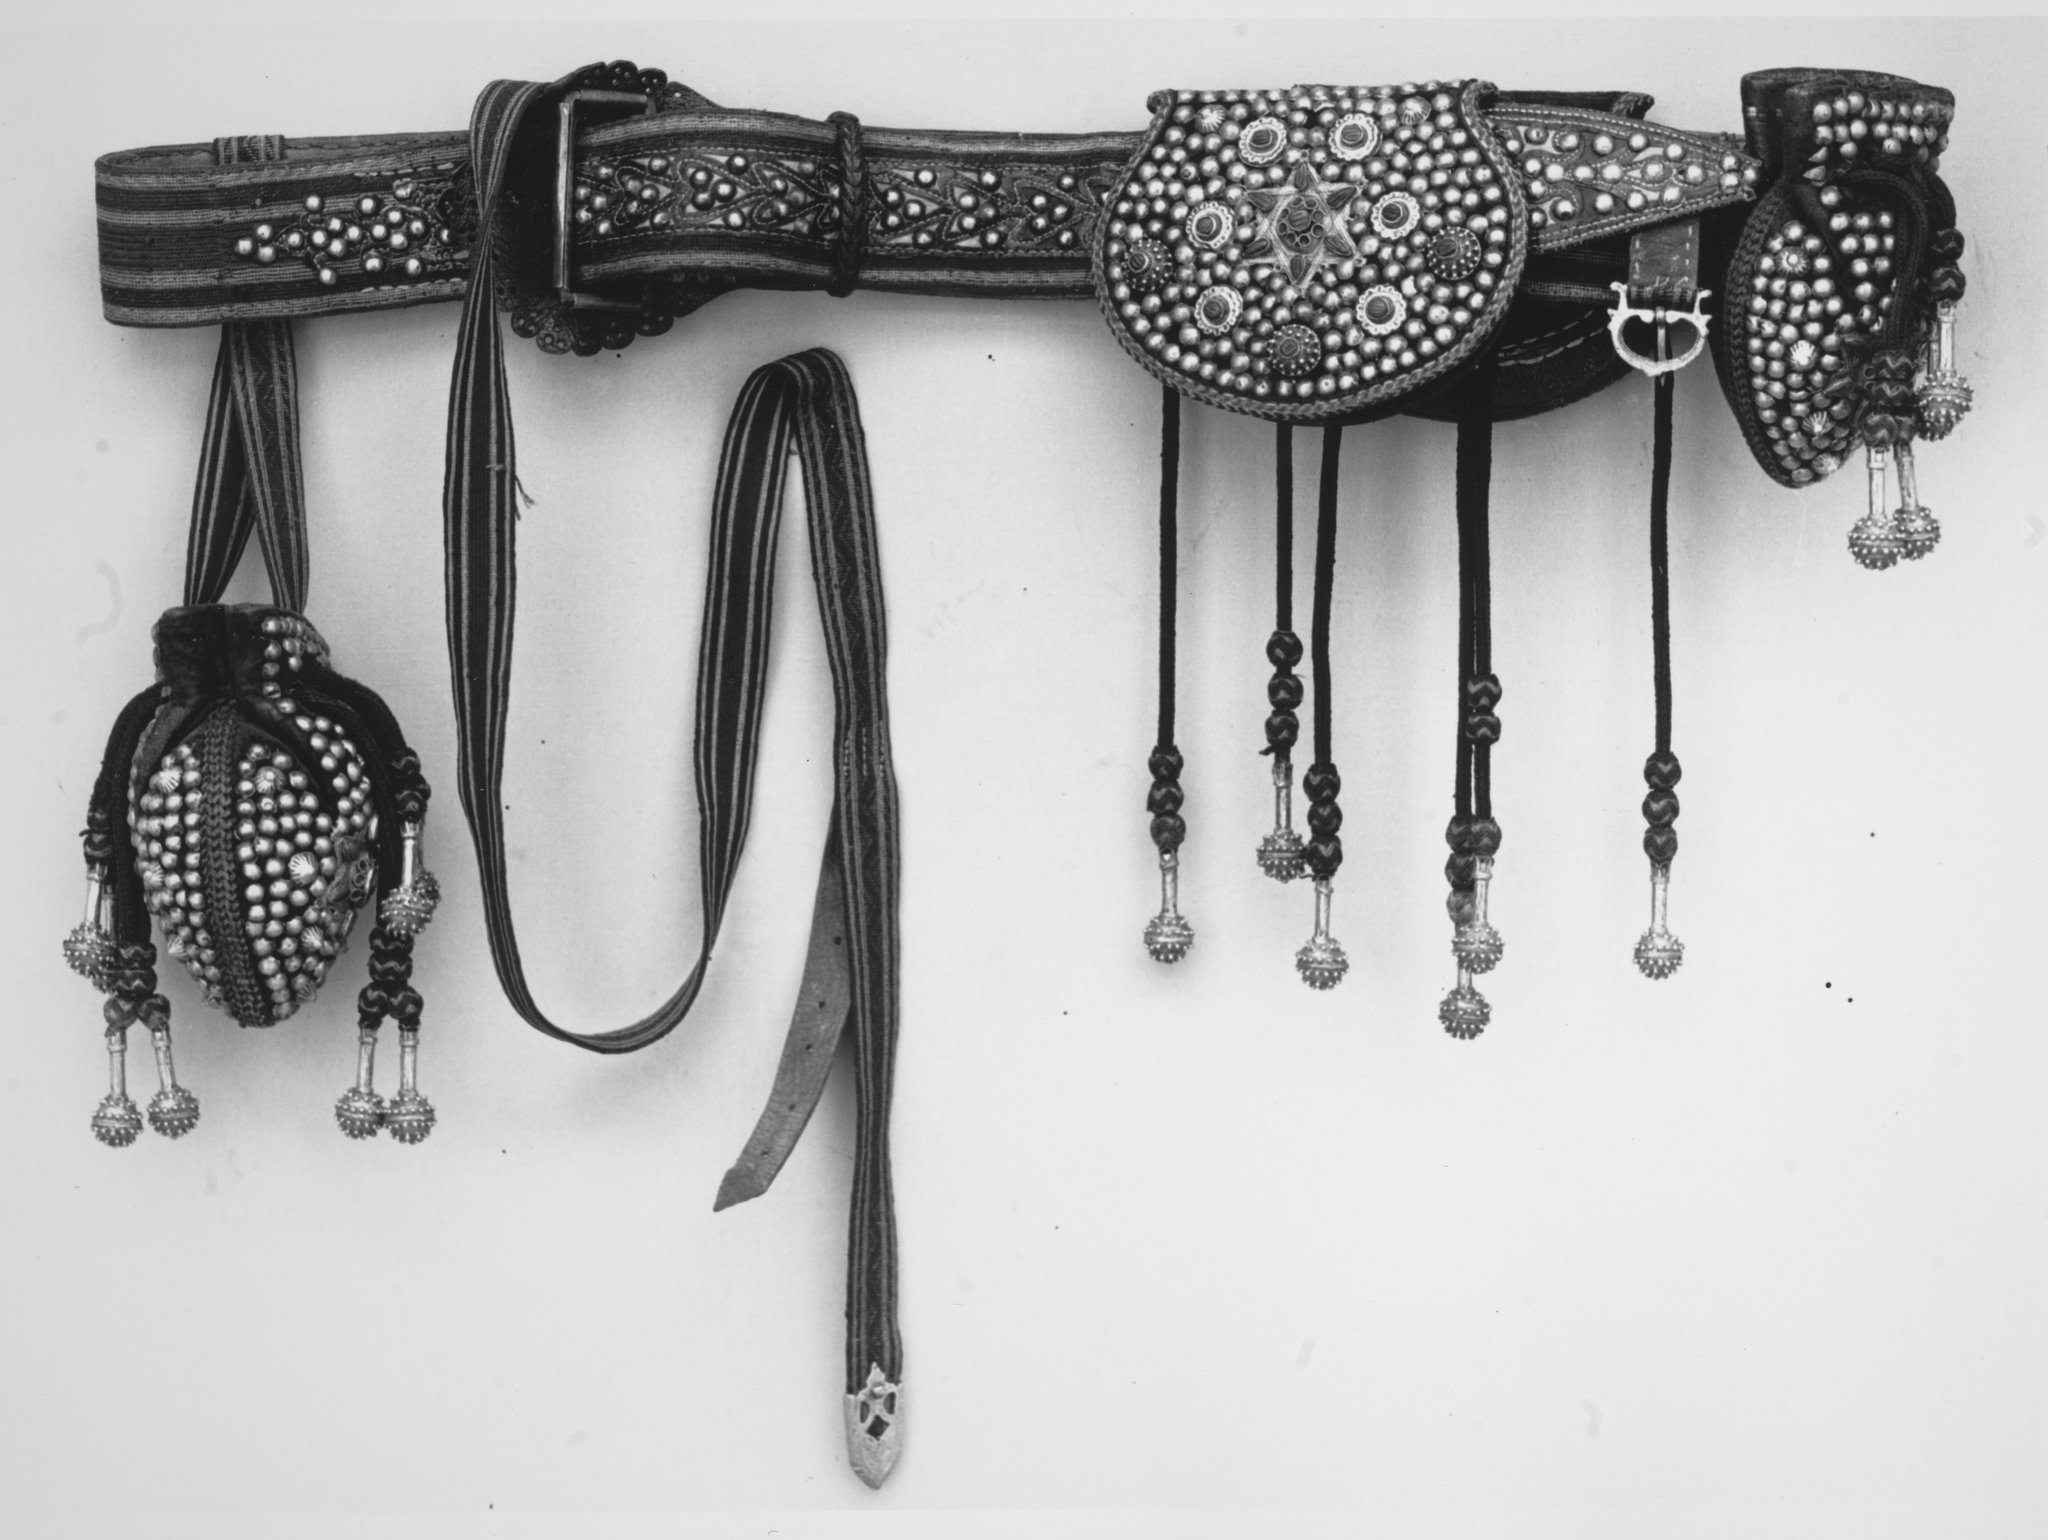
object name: belt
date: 1801-1900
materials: leather, metal, silver, stone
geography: iran